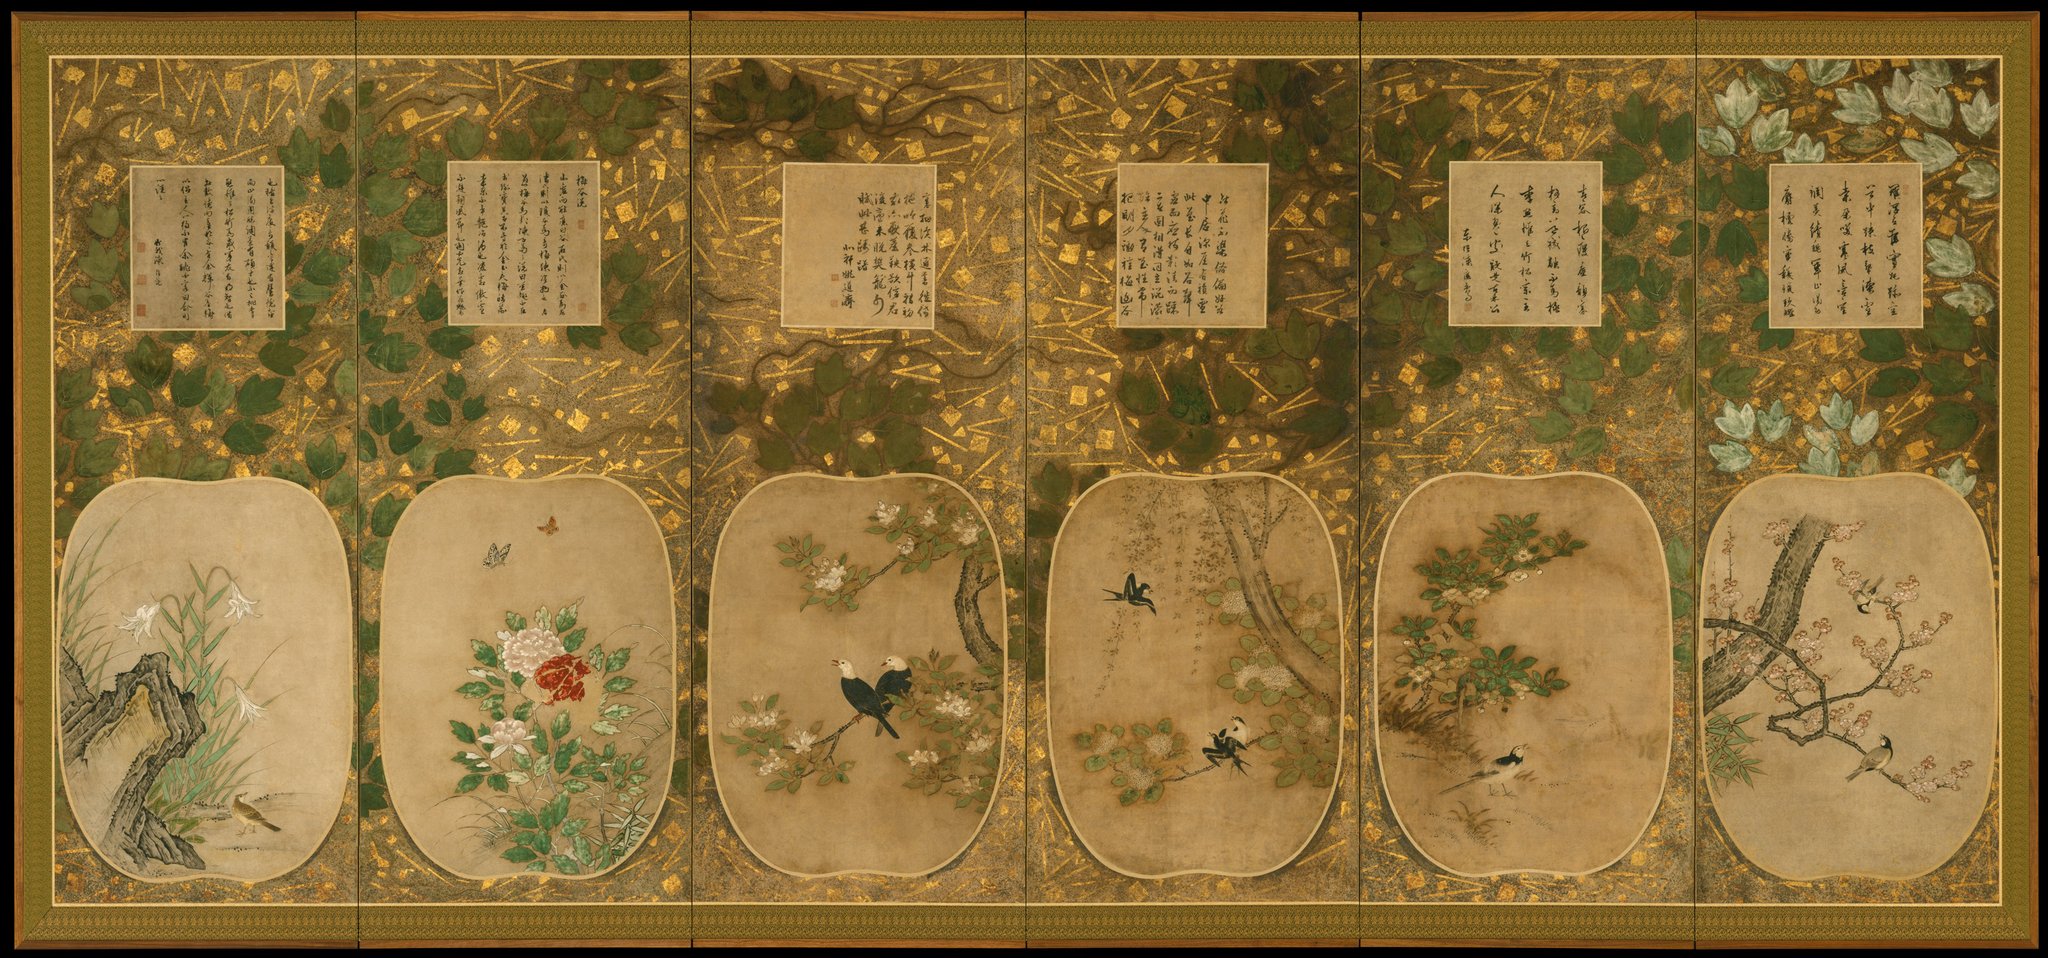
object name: screen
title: Birds and Flowers of the Twelve Months with Chinese Calligraphy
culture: japanese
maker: kano school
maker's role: artist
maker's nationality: japanese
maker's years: 1476-1559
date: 1501-1600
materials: gold leaf, ink, panel, paper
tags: birds,flowers